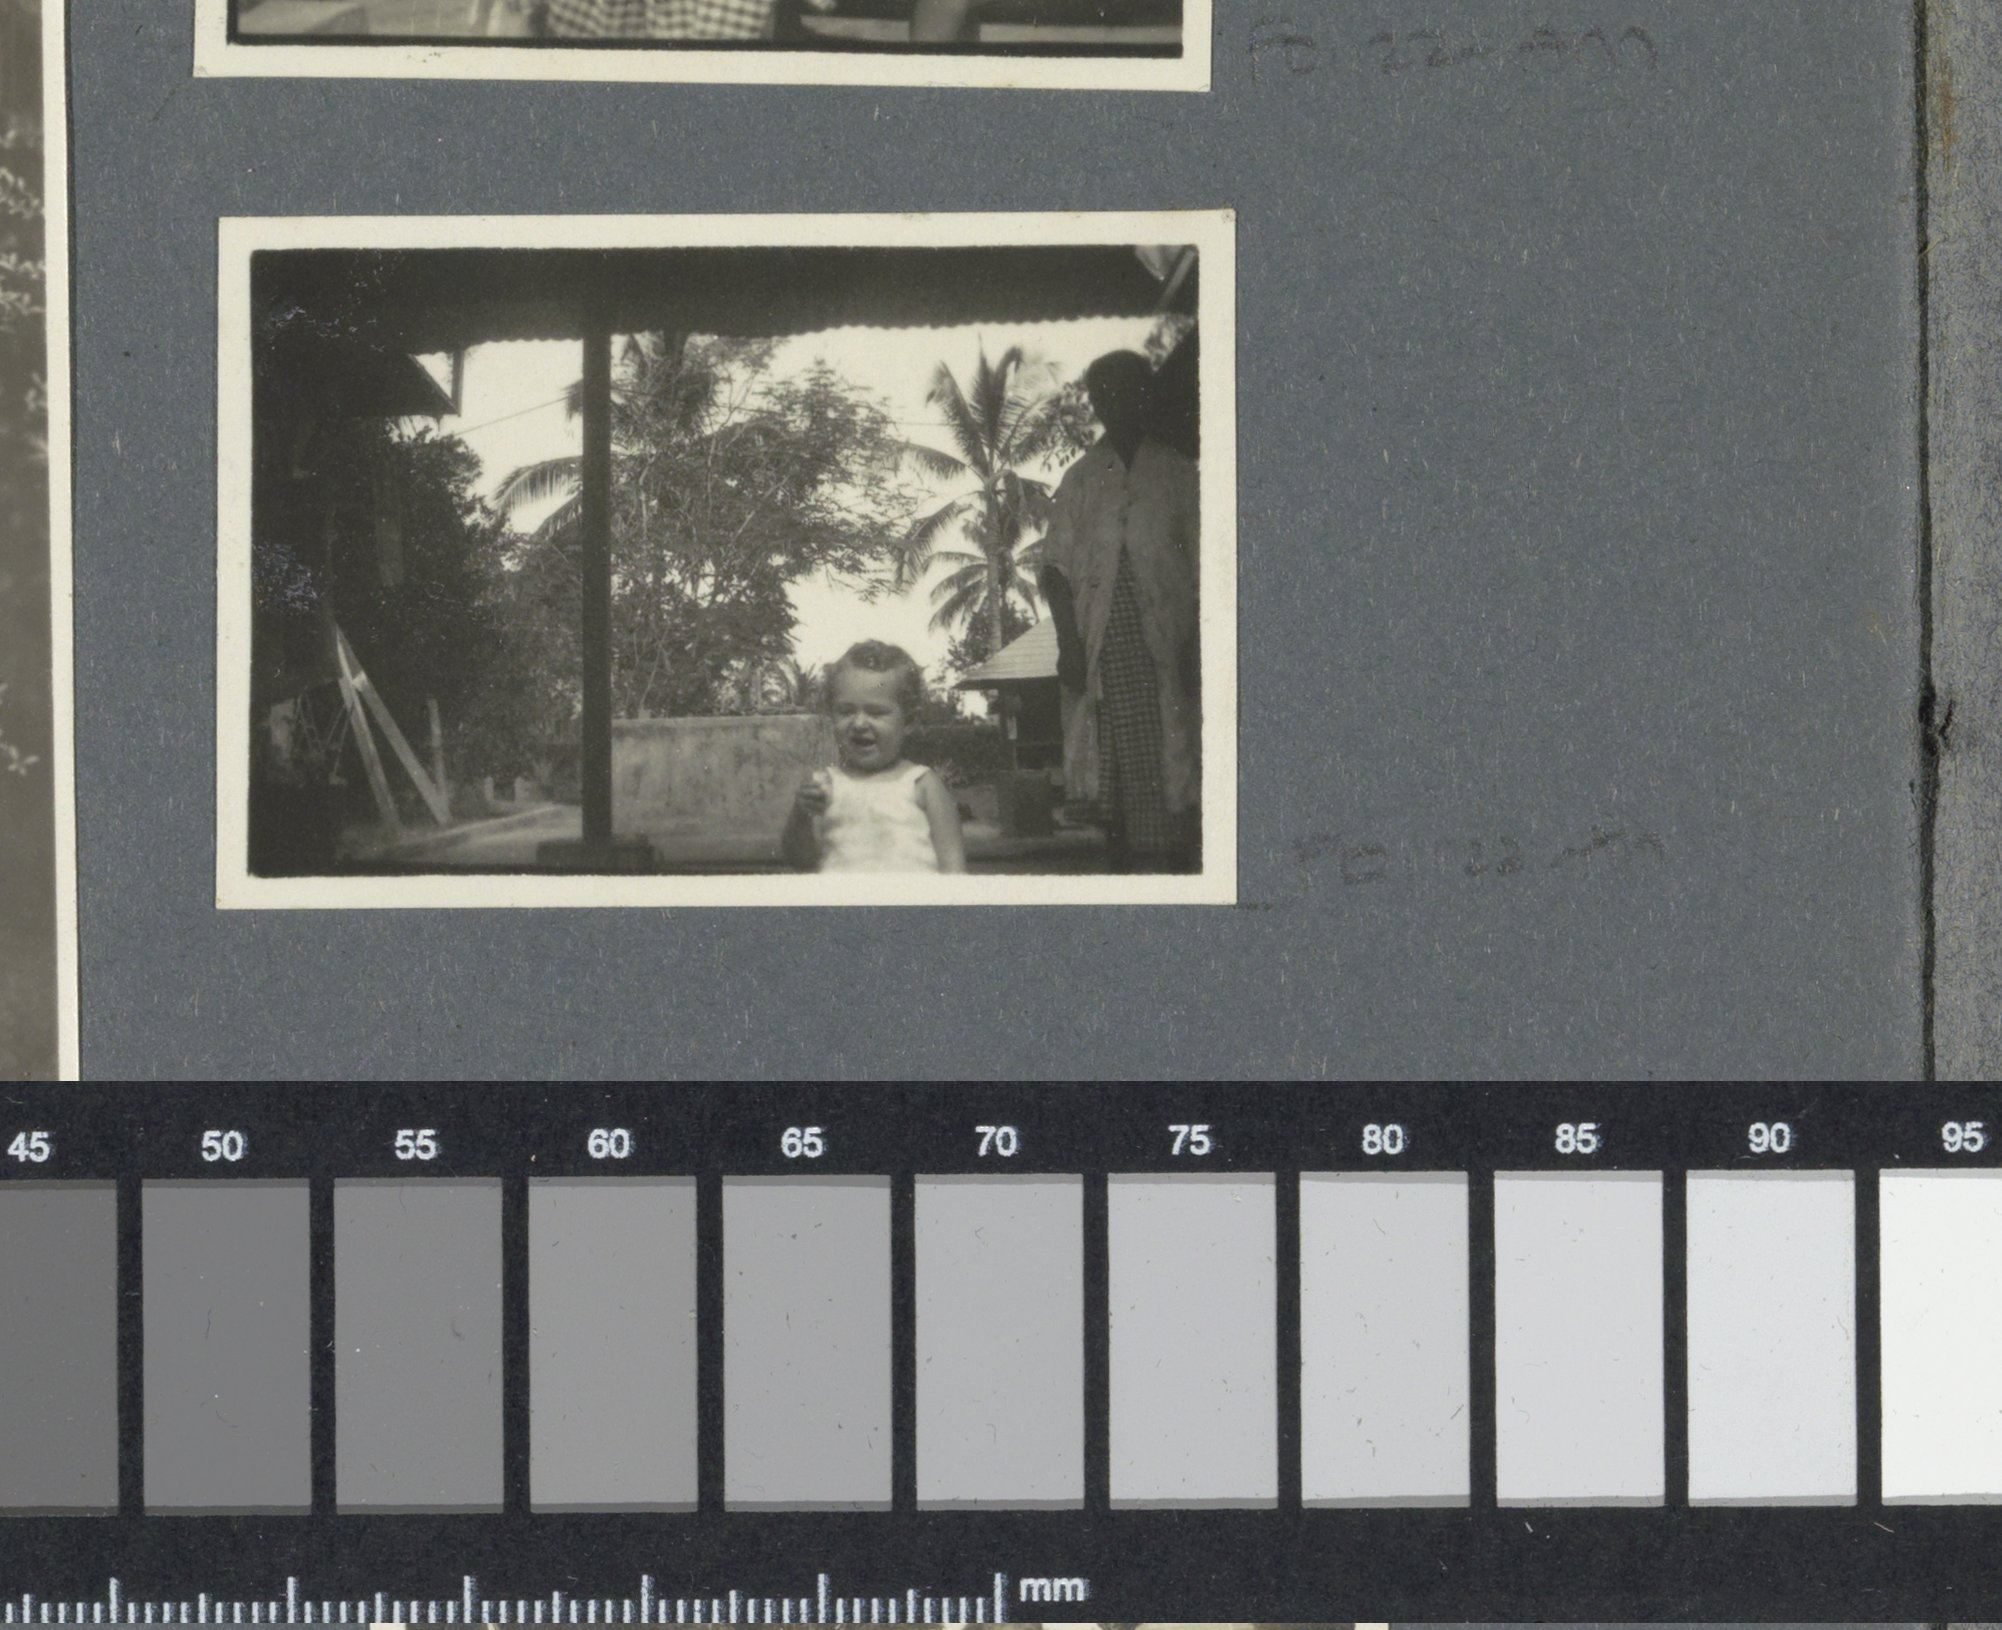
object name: photograph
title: Indische vrouw met kind, vermoedelijk kind van de familie Bergsma met baboe op Sumatra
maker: Anonymous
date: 1914-1926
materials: photographic support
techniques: gelatin silver print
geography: sumatra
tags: baby-sitter, child, taking care of children, sumatra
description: Onderdeel van fotoalbum met opnames van de familie Bergsma in Tandjong Poera en Rantan Pandjang (Sumatra).